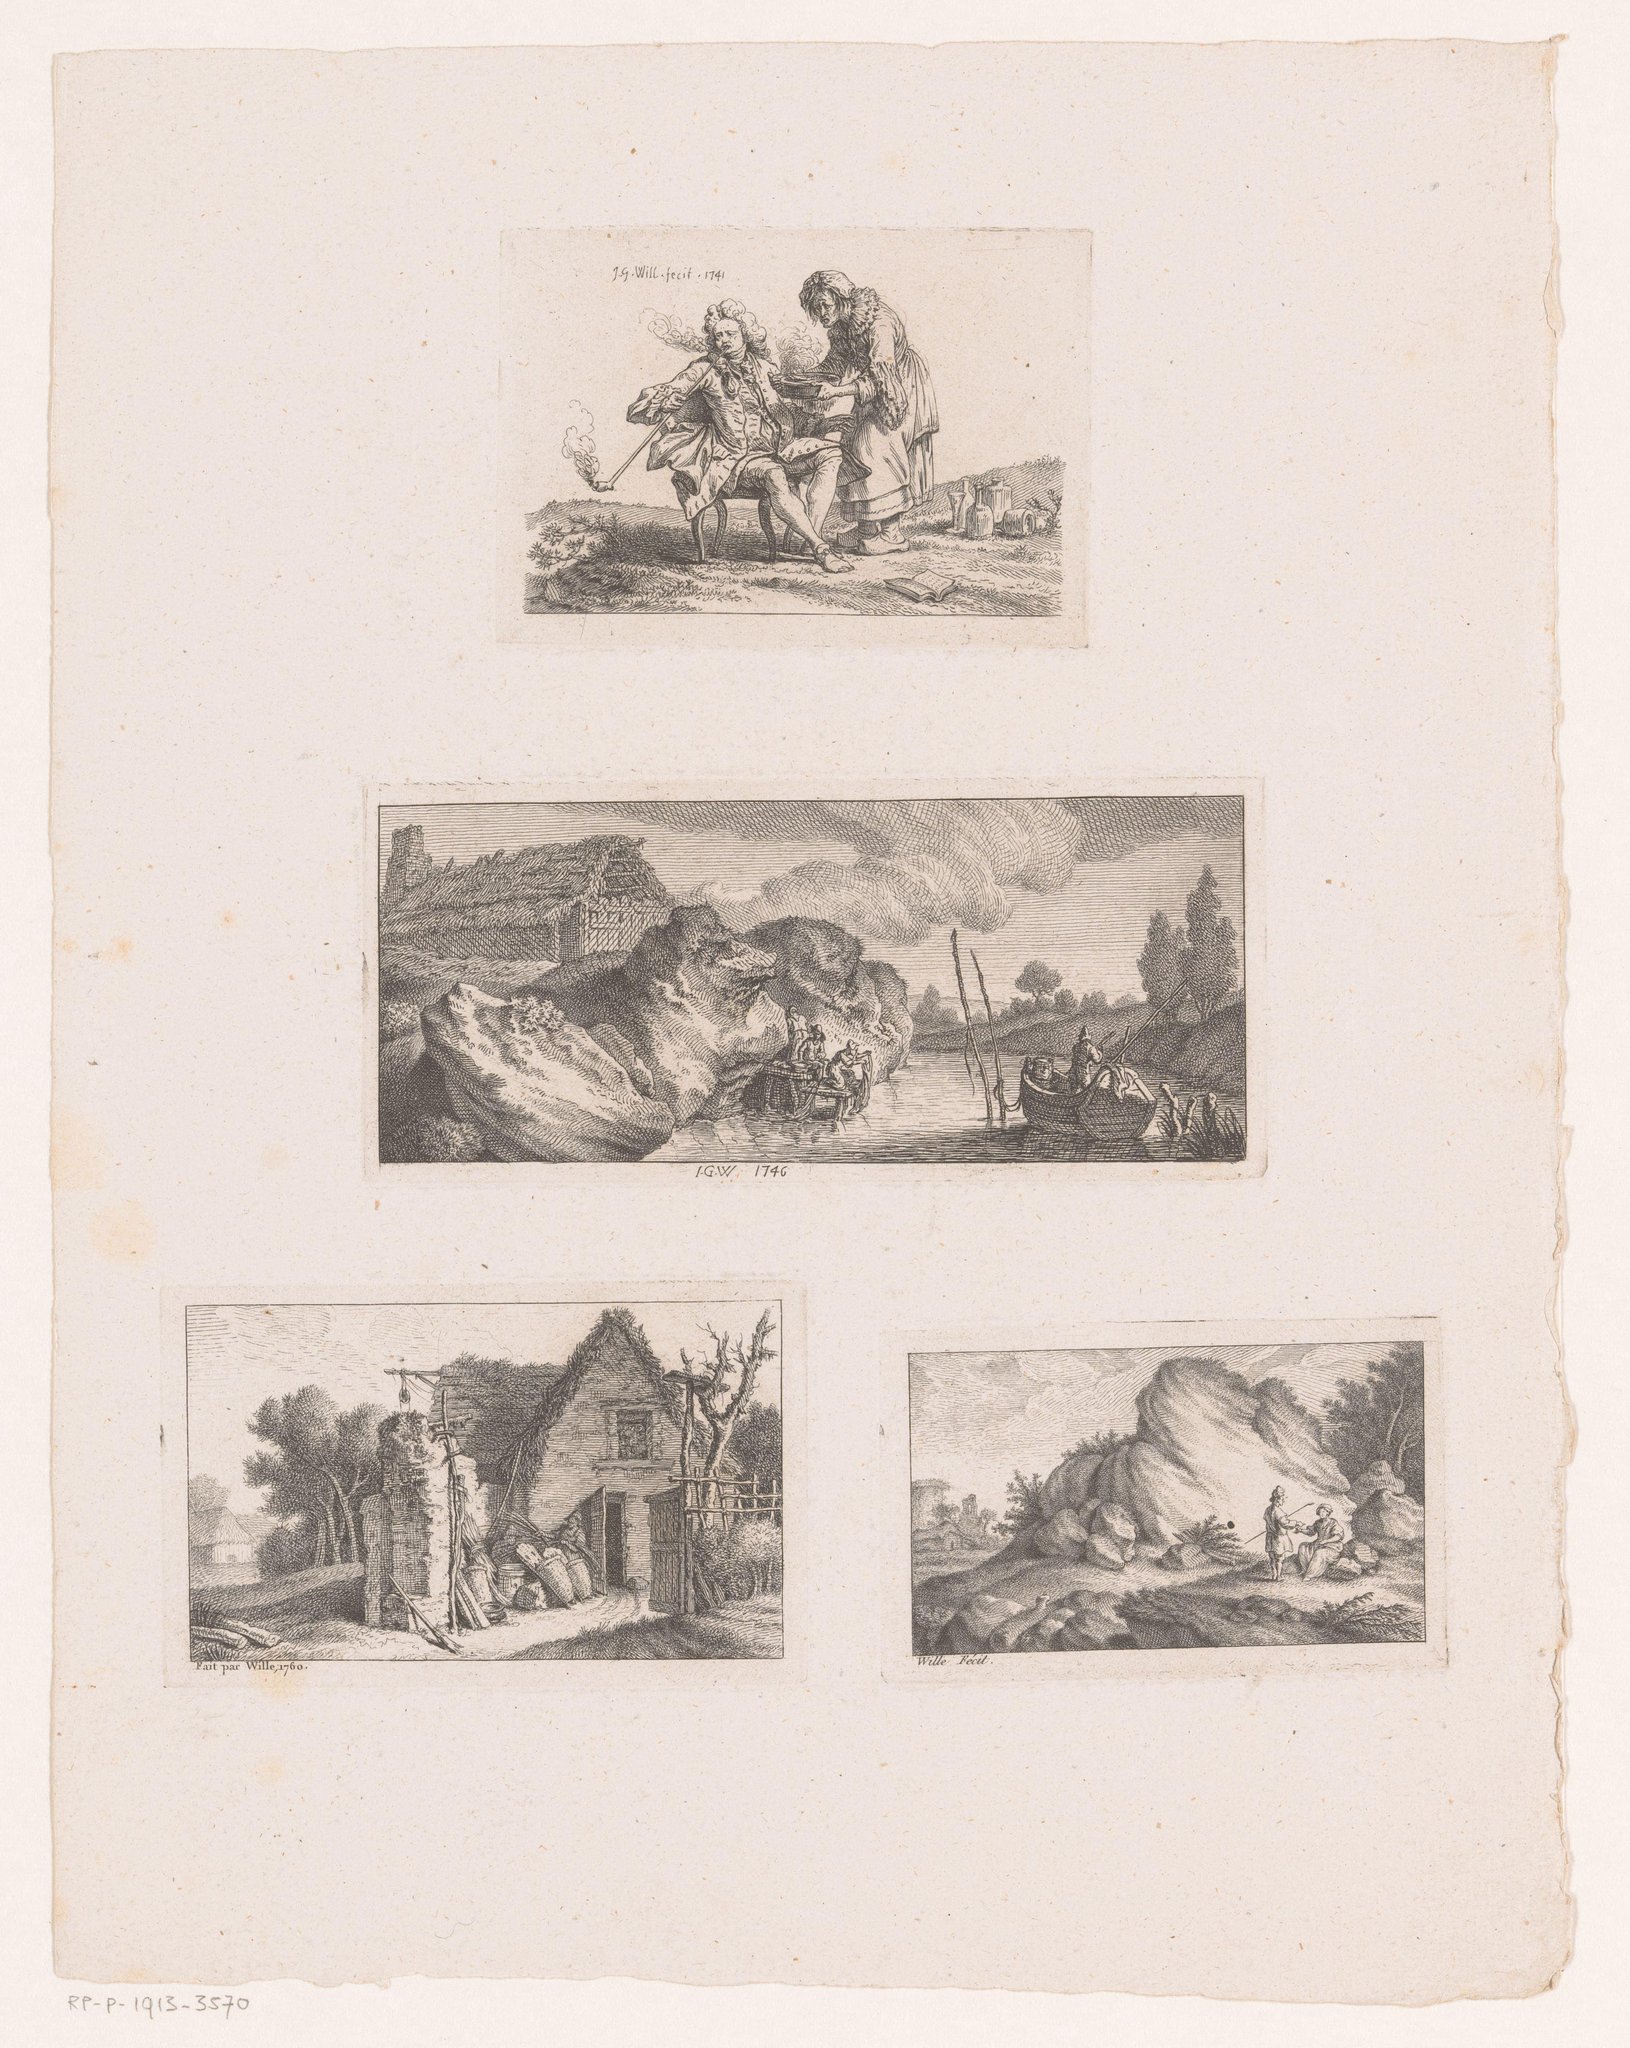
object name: print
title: Recueil De Paysages et autres Figures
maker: johann georg wille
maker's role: draughtsman, print maker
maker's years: 1715-1808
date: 1738-1801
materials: paper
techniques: etching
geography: france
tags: landscapes with waters, waterscapes, seascapes (in the temperate zone), pipe ~ tobacco, landscape with ruins, laundering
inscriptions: collector's mark: Lugt 2228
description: Deze vier prenten, samen gedrukt op een niet versneden blad, maken deel uit van een serie bestaande uit een titelprent en 36 prenten met verschillende onderwerpen.